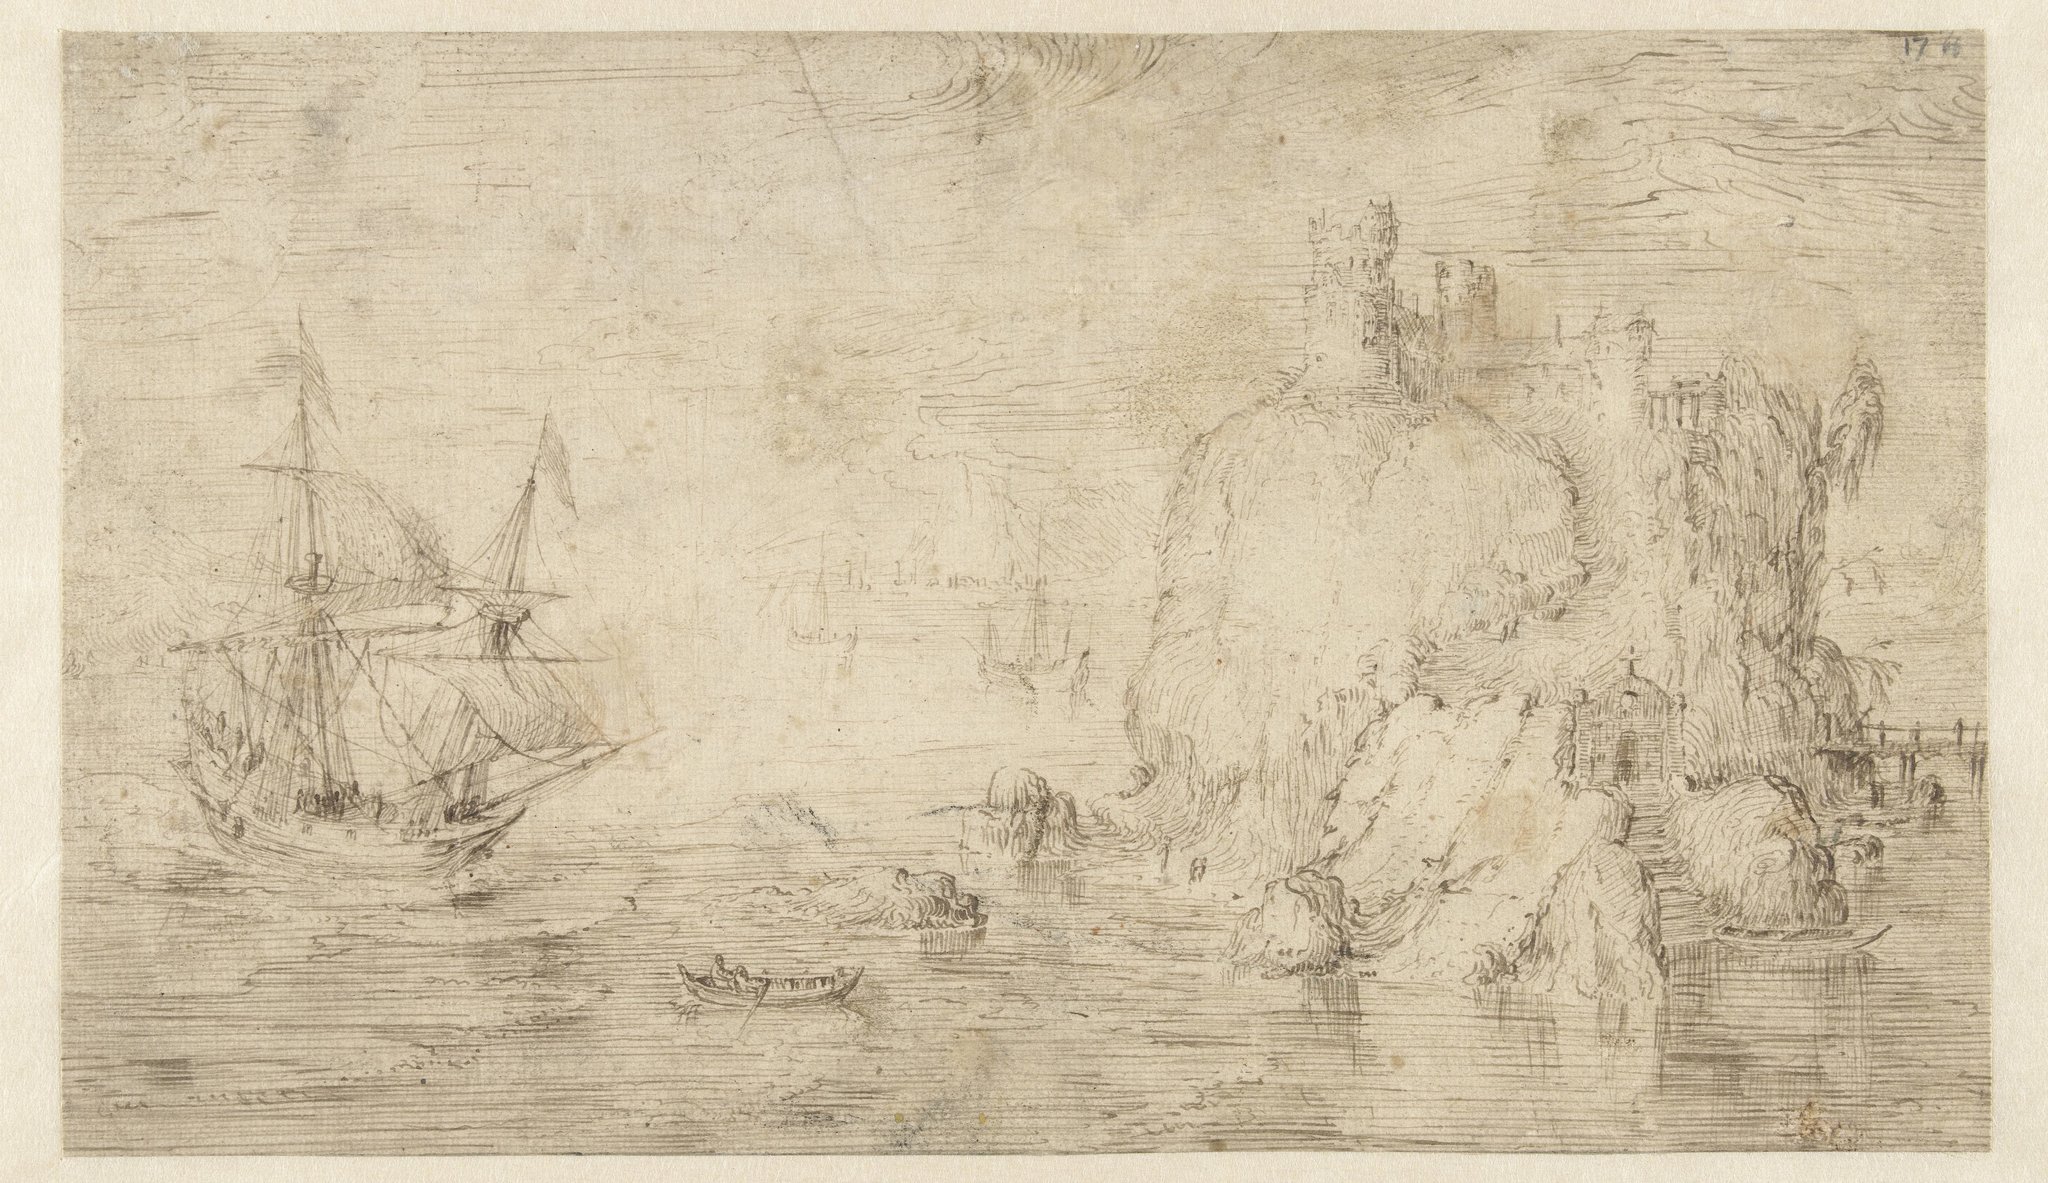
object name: drawing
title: Zeegezicht met een schip bij een eiland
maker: cornelis claesz van wieringen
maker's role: draughtsman, painter, print maker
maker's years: 1577-1633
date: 1590-1633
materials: ink, paper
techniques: pen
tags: sailing-ship, sailing-boat, sea (seascape)